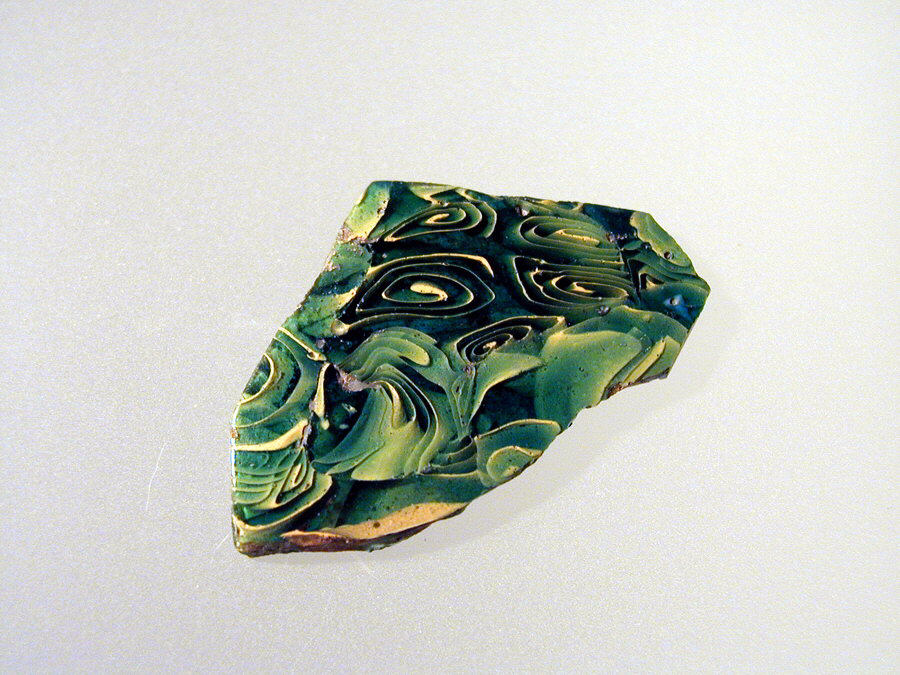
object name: fragment, mosaic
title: Glass mosaic fragment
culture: roman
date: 34 BCE-33 CE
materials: glass